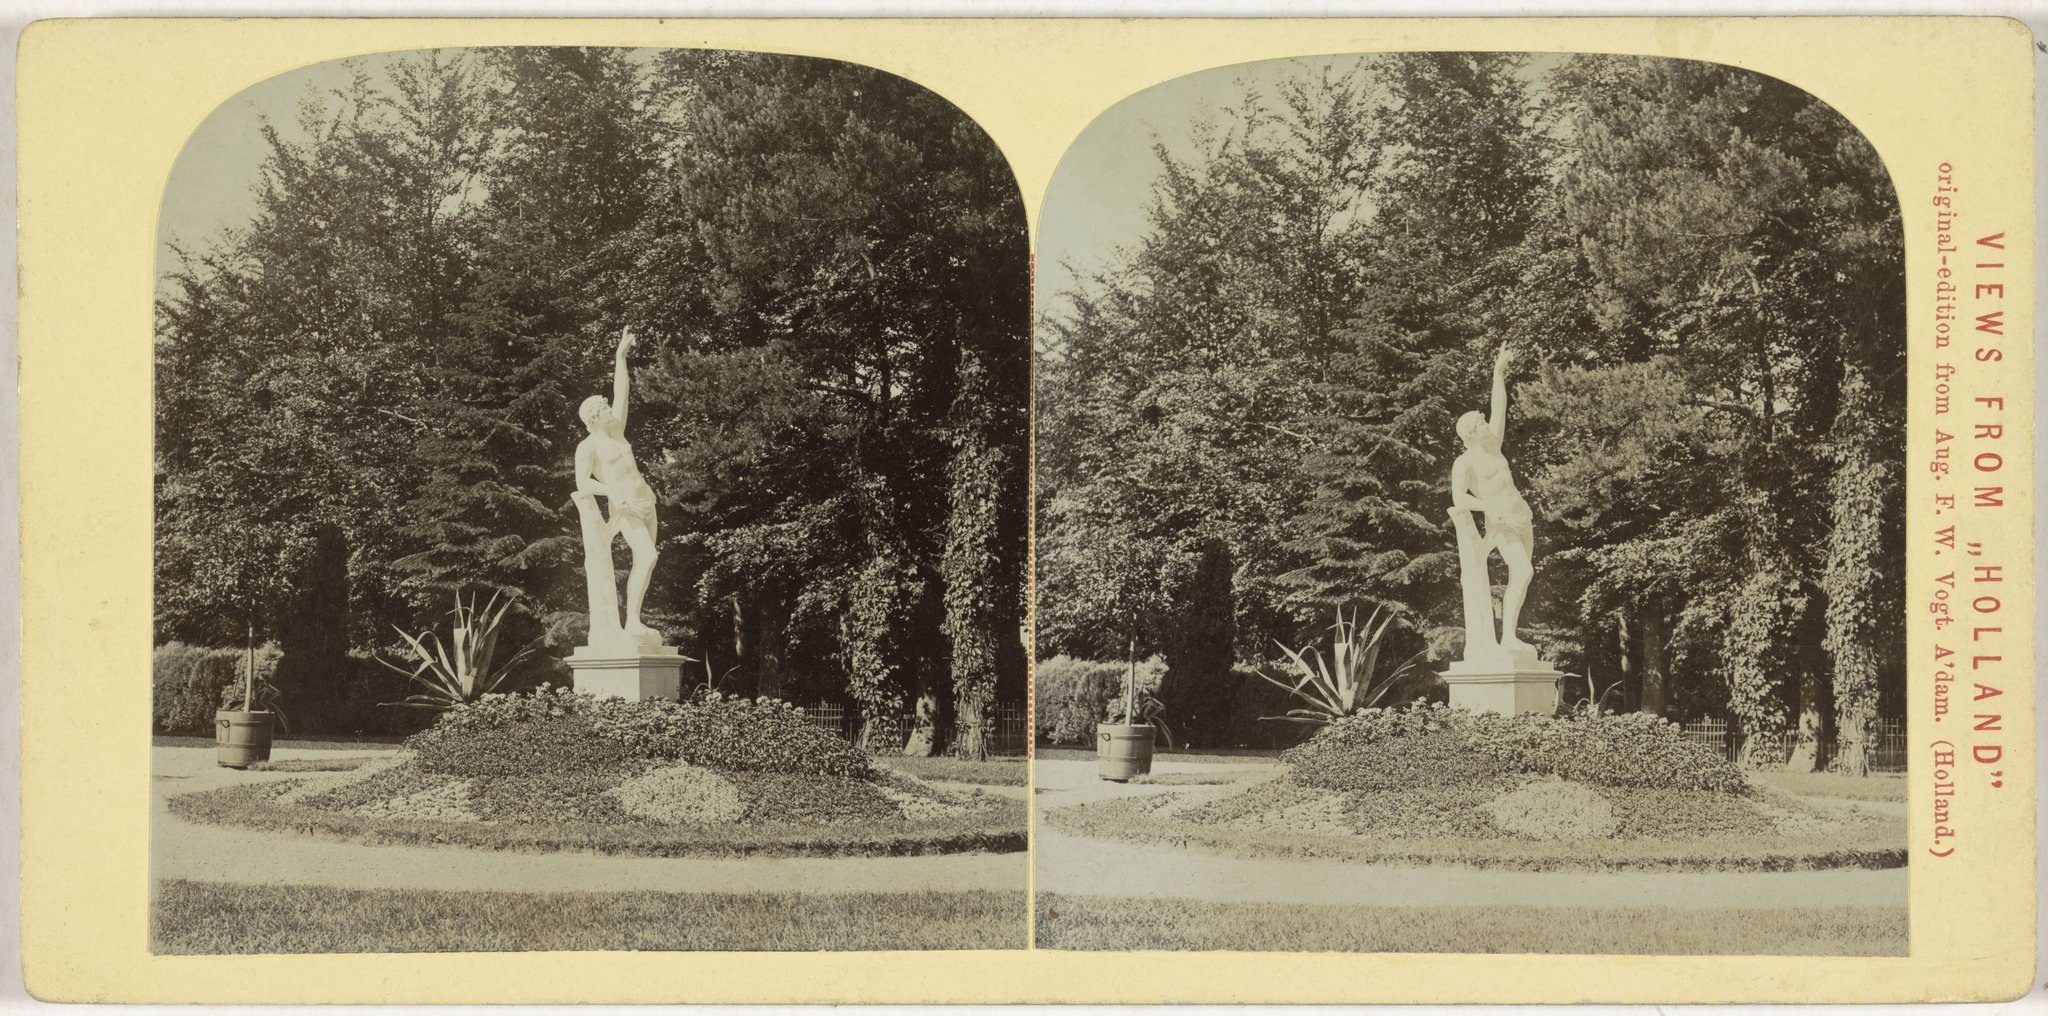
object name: stereograph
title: Views from "Holland"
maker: august frederik willem vogt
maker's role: fotograaf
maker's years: 1871-1922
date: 1870-1920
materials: cardboard, paper, photographic support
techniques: gelatin silver print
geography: amsterdam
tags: baarn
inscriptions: annotation: ‘Baarn’, inscription: ‘VIEWS FROM ''HOLLAND''’